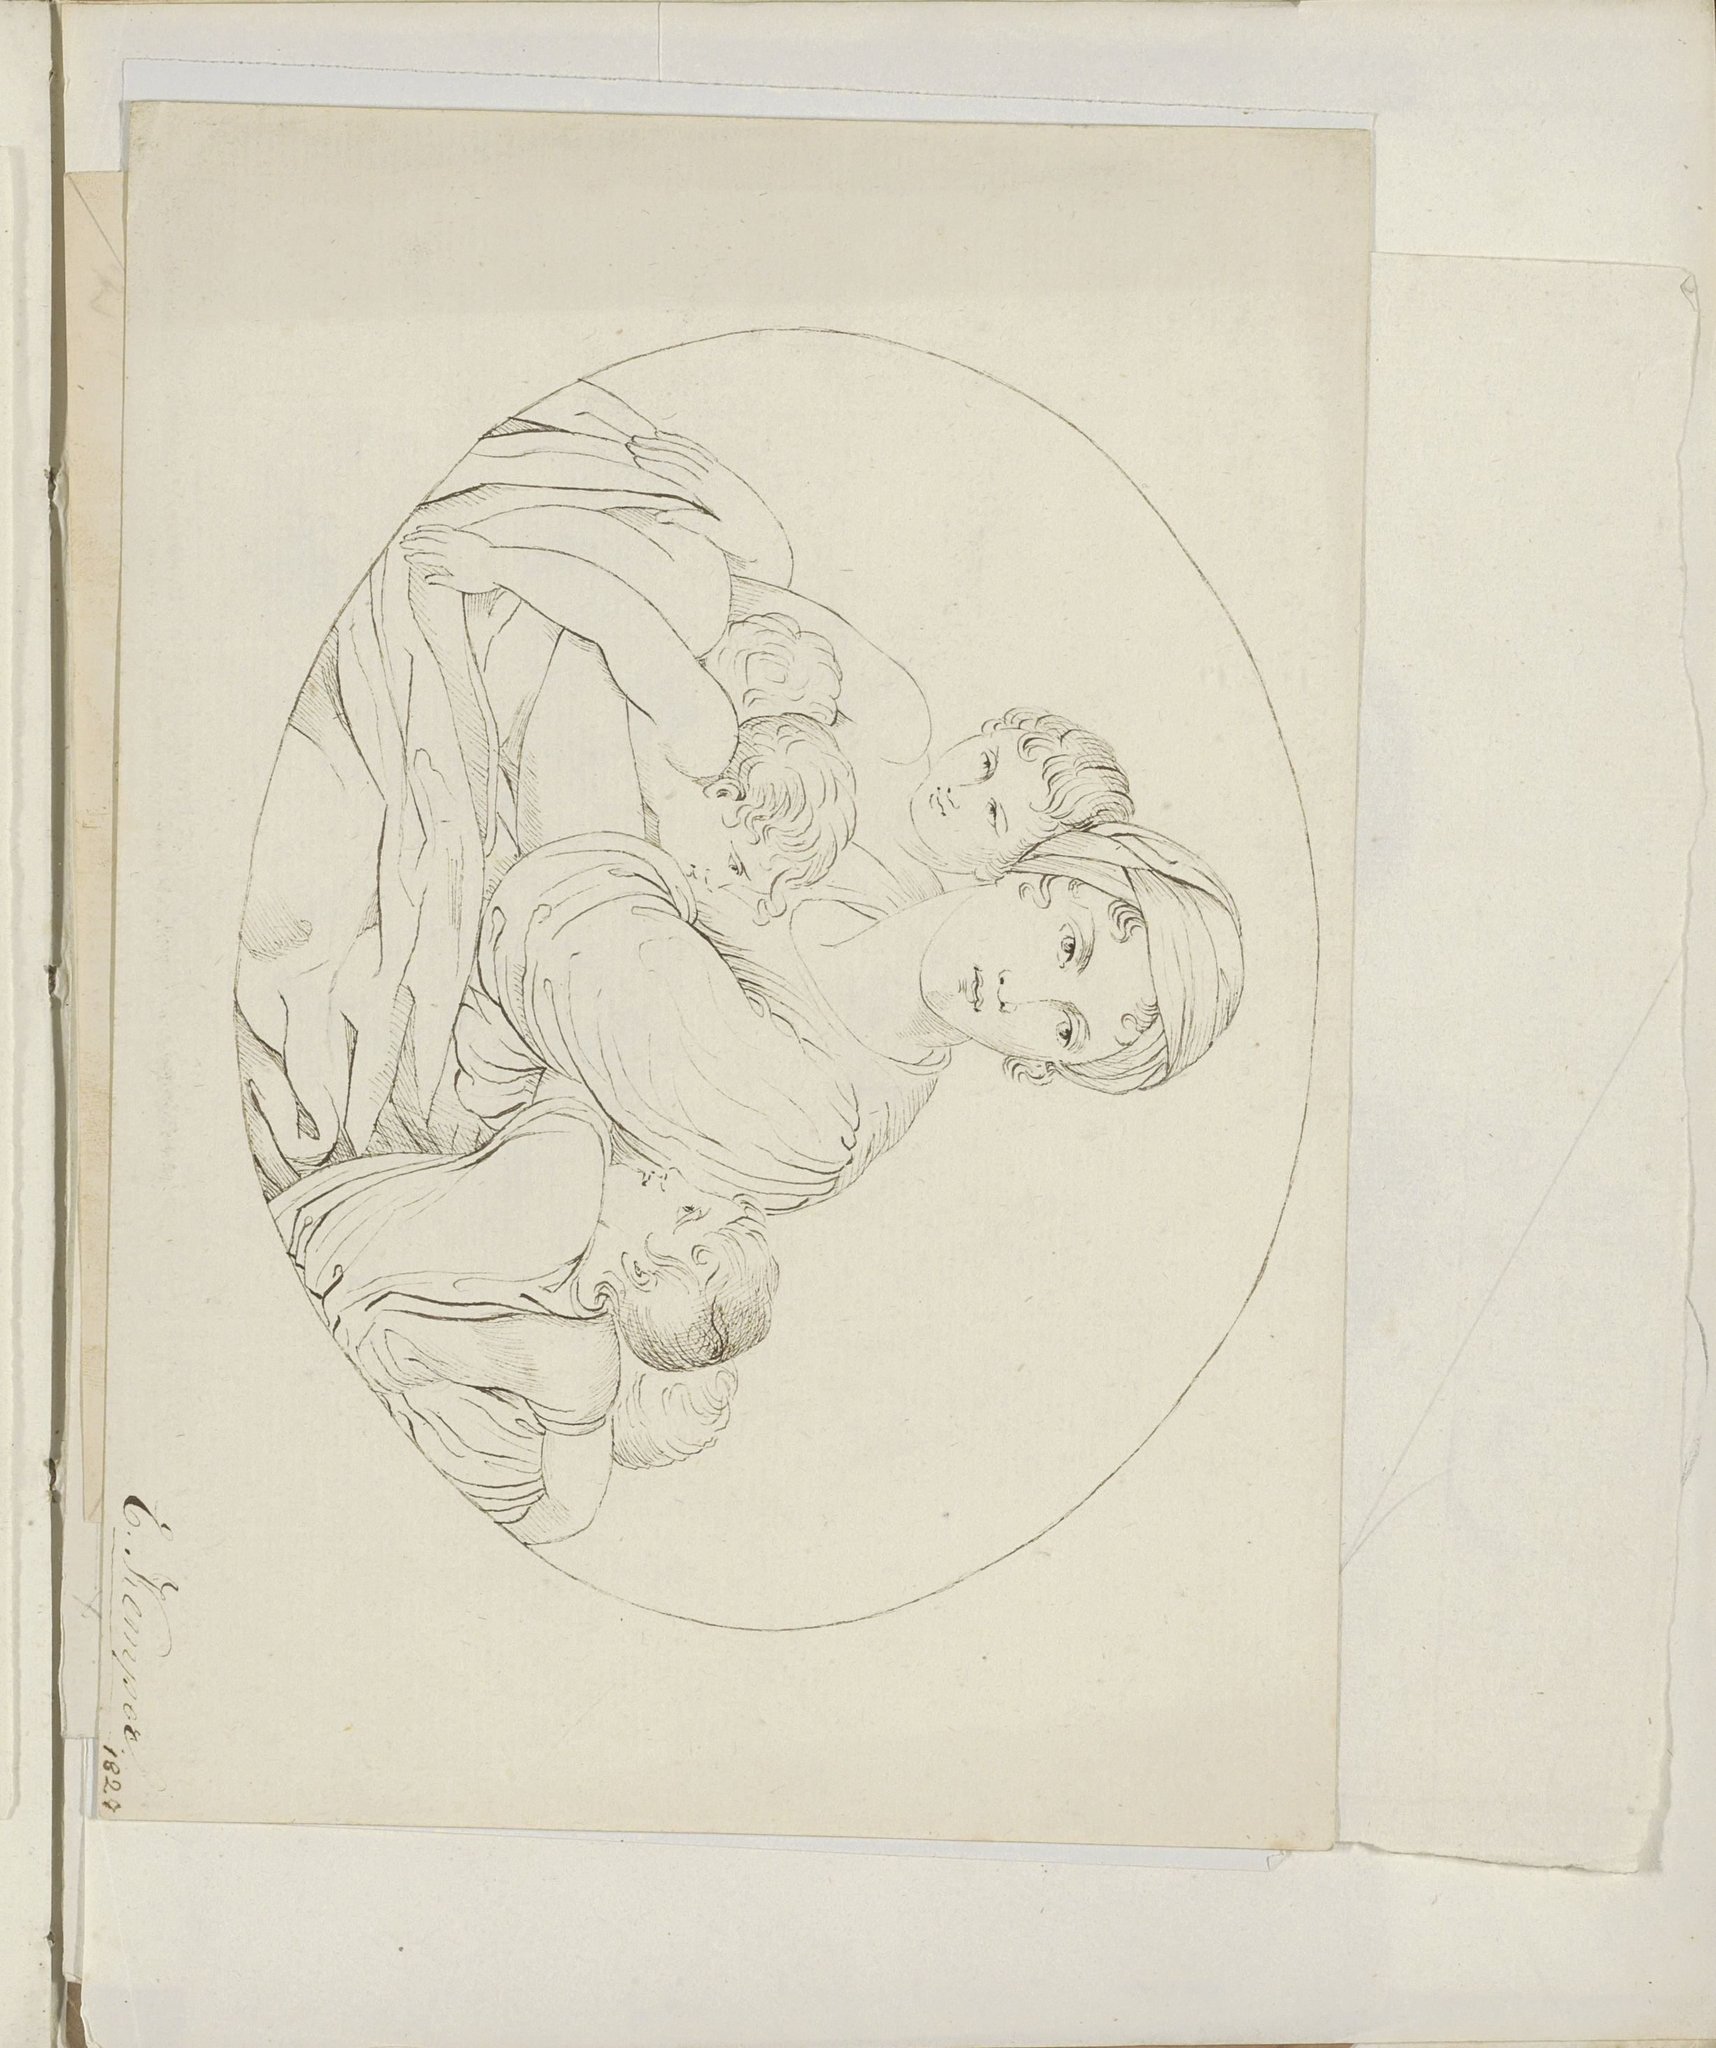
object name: sketchbook leaf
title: Moeder met vijf kinderen in ovaal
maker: jonkvrouw elisabeth kemper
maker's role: draughtsman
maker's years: 1799-1871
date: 1827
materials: ink, paper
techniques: pen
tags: mother and child(ren), woman and child(ren) (family group)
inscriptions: signature and date: ‘E. Kemper/ 1827’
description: De kinderen staan rondom de zittende moeder, die een doek over het hoofd gedrapeerd heeft. Losse tekening tussen blad 94 en het achterste schutblad uit een schetsboek met 94 bladen.